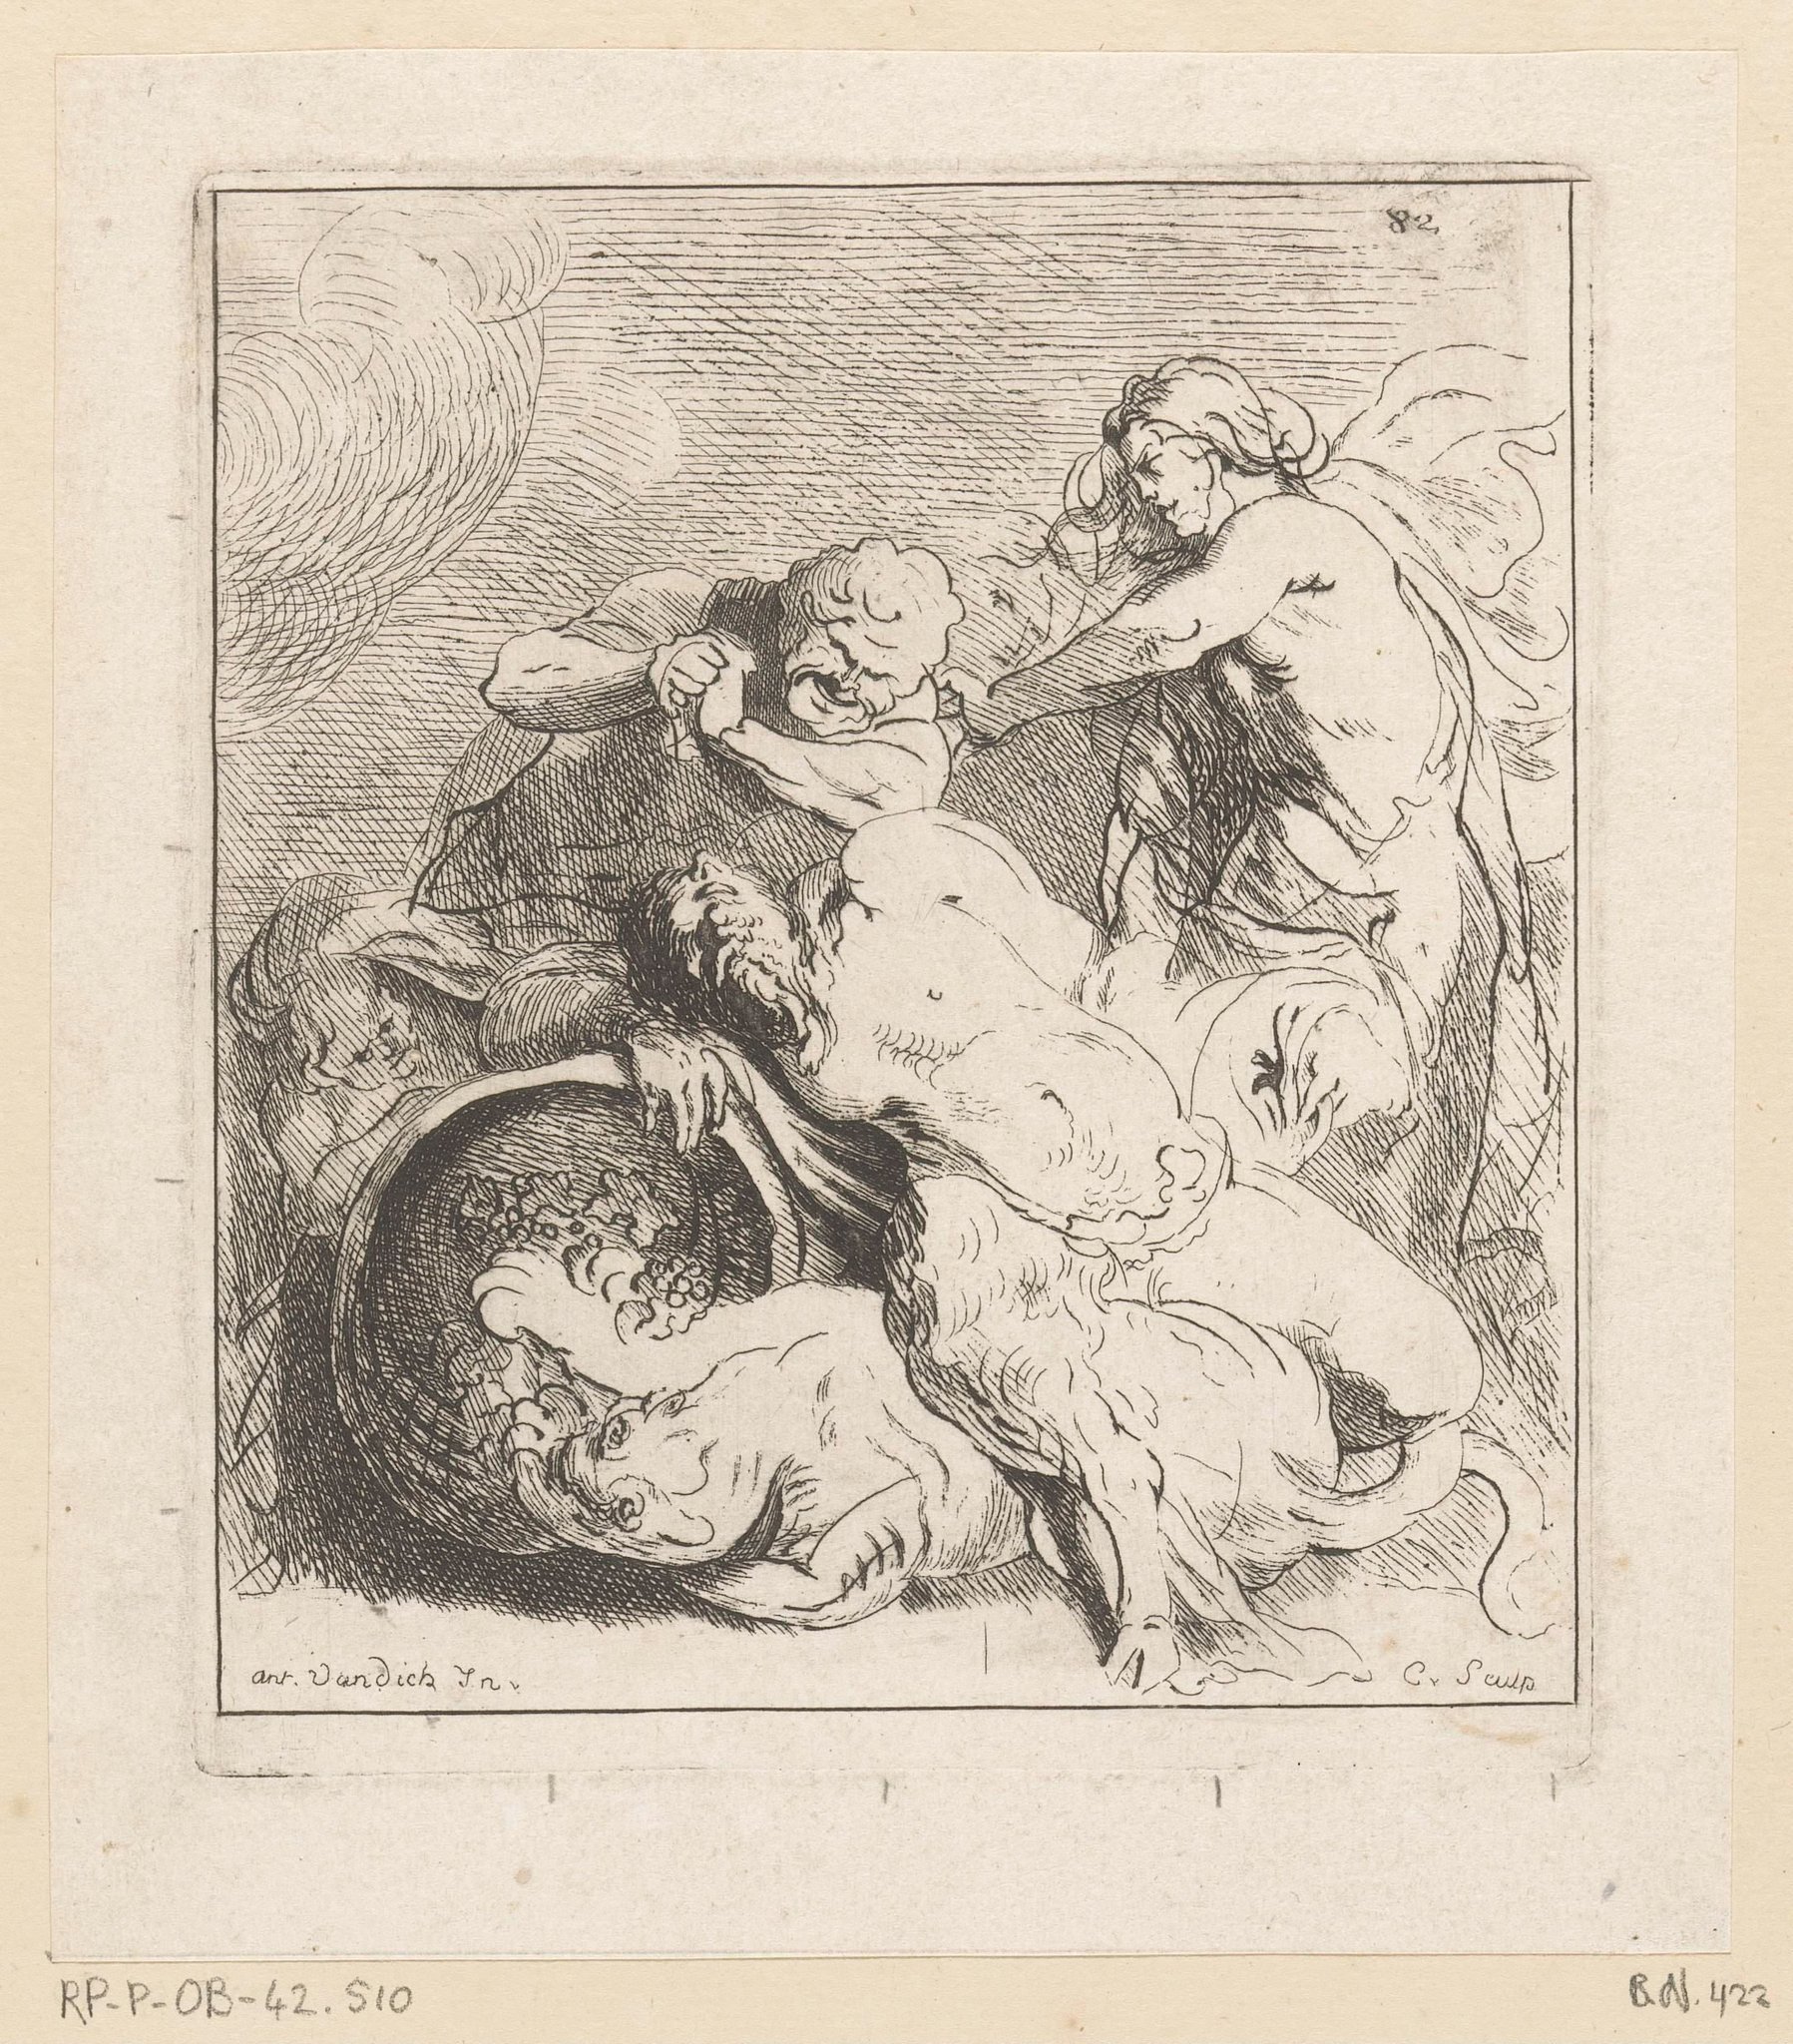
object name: print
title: Dronkenschap van Silenus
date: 1702-1765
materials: paper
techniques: etching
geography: france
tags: attributes of bacchus, beasts of prey, predatory animals: panther, (story of) silenus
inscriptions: collector's mark: Lugt 240